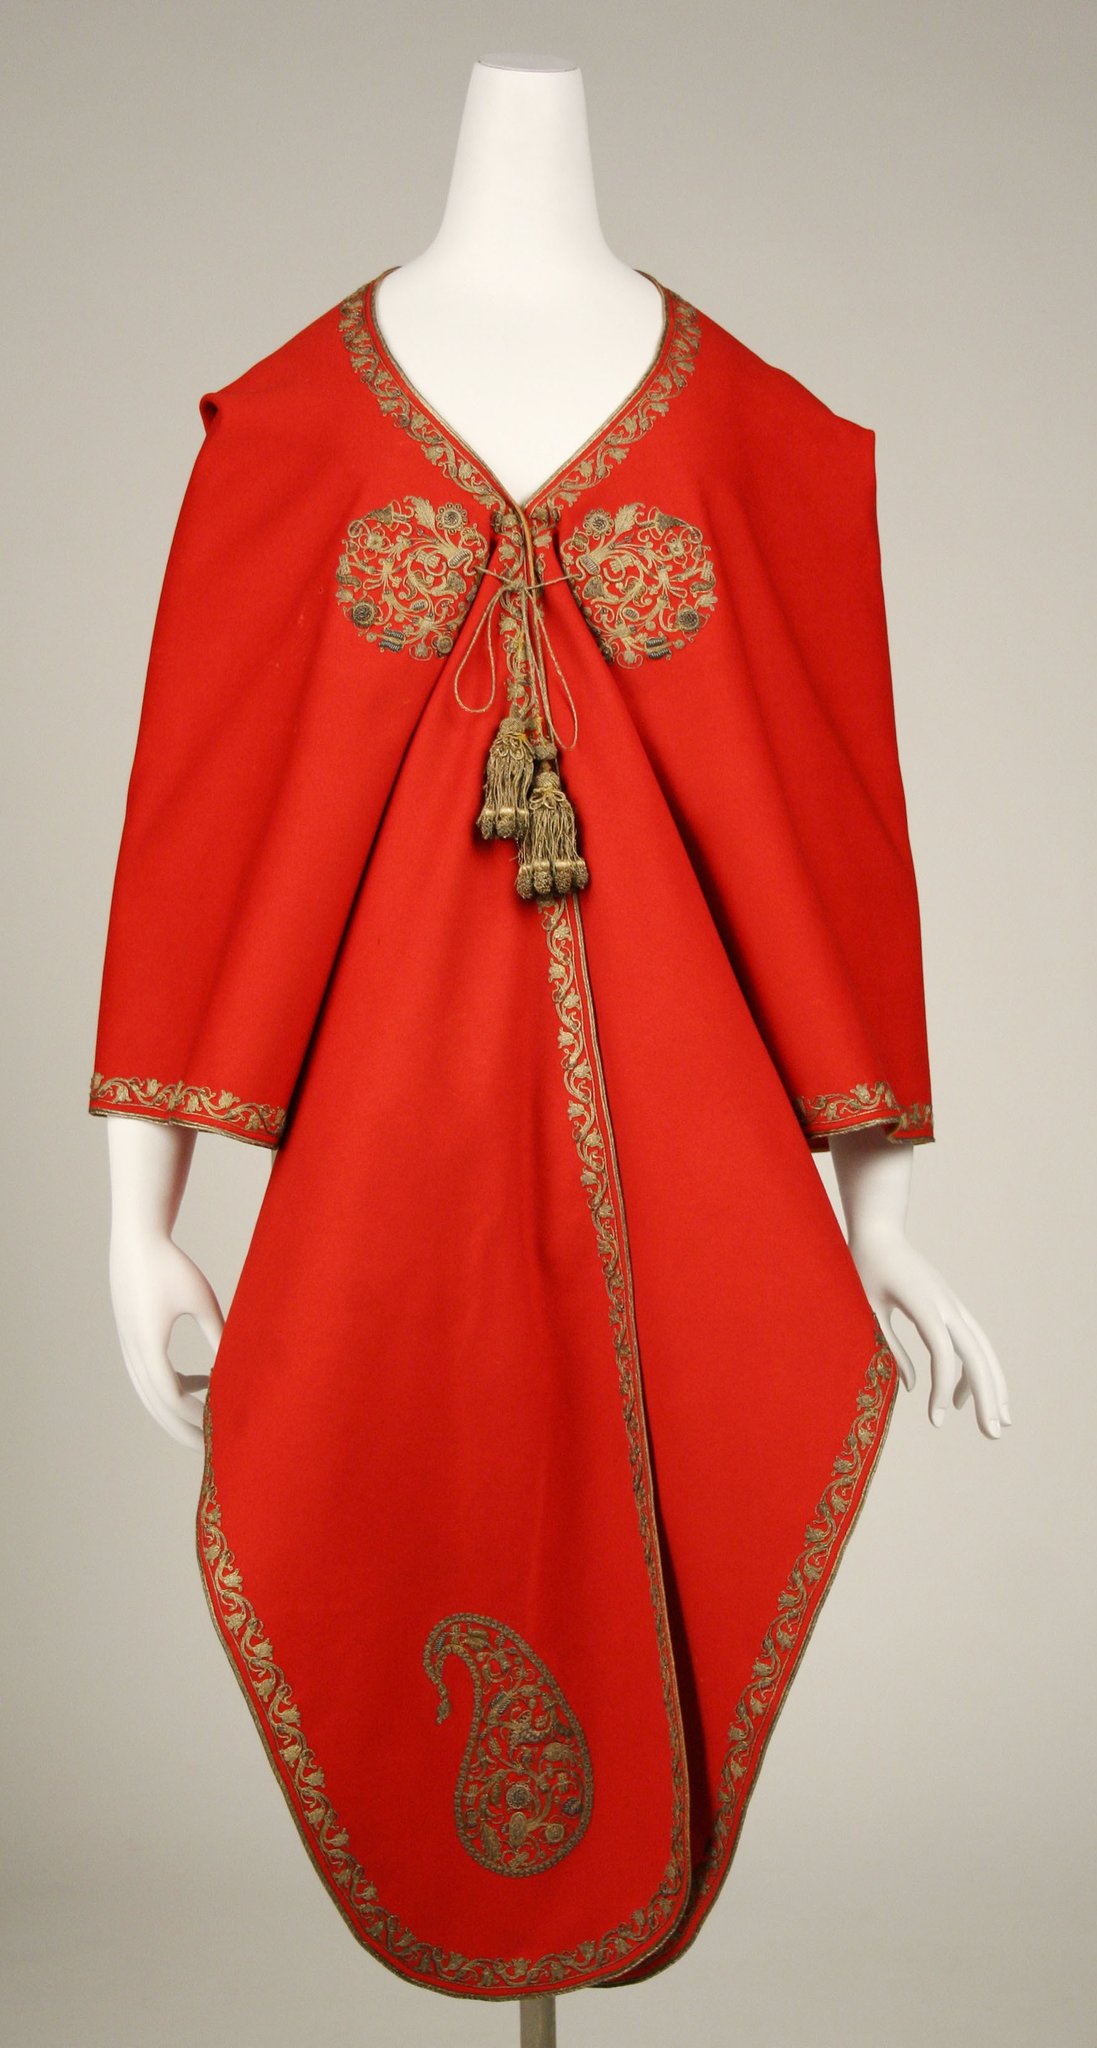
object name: bashlik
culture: european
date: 1860-1869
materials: metal thread, wool